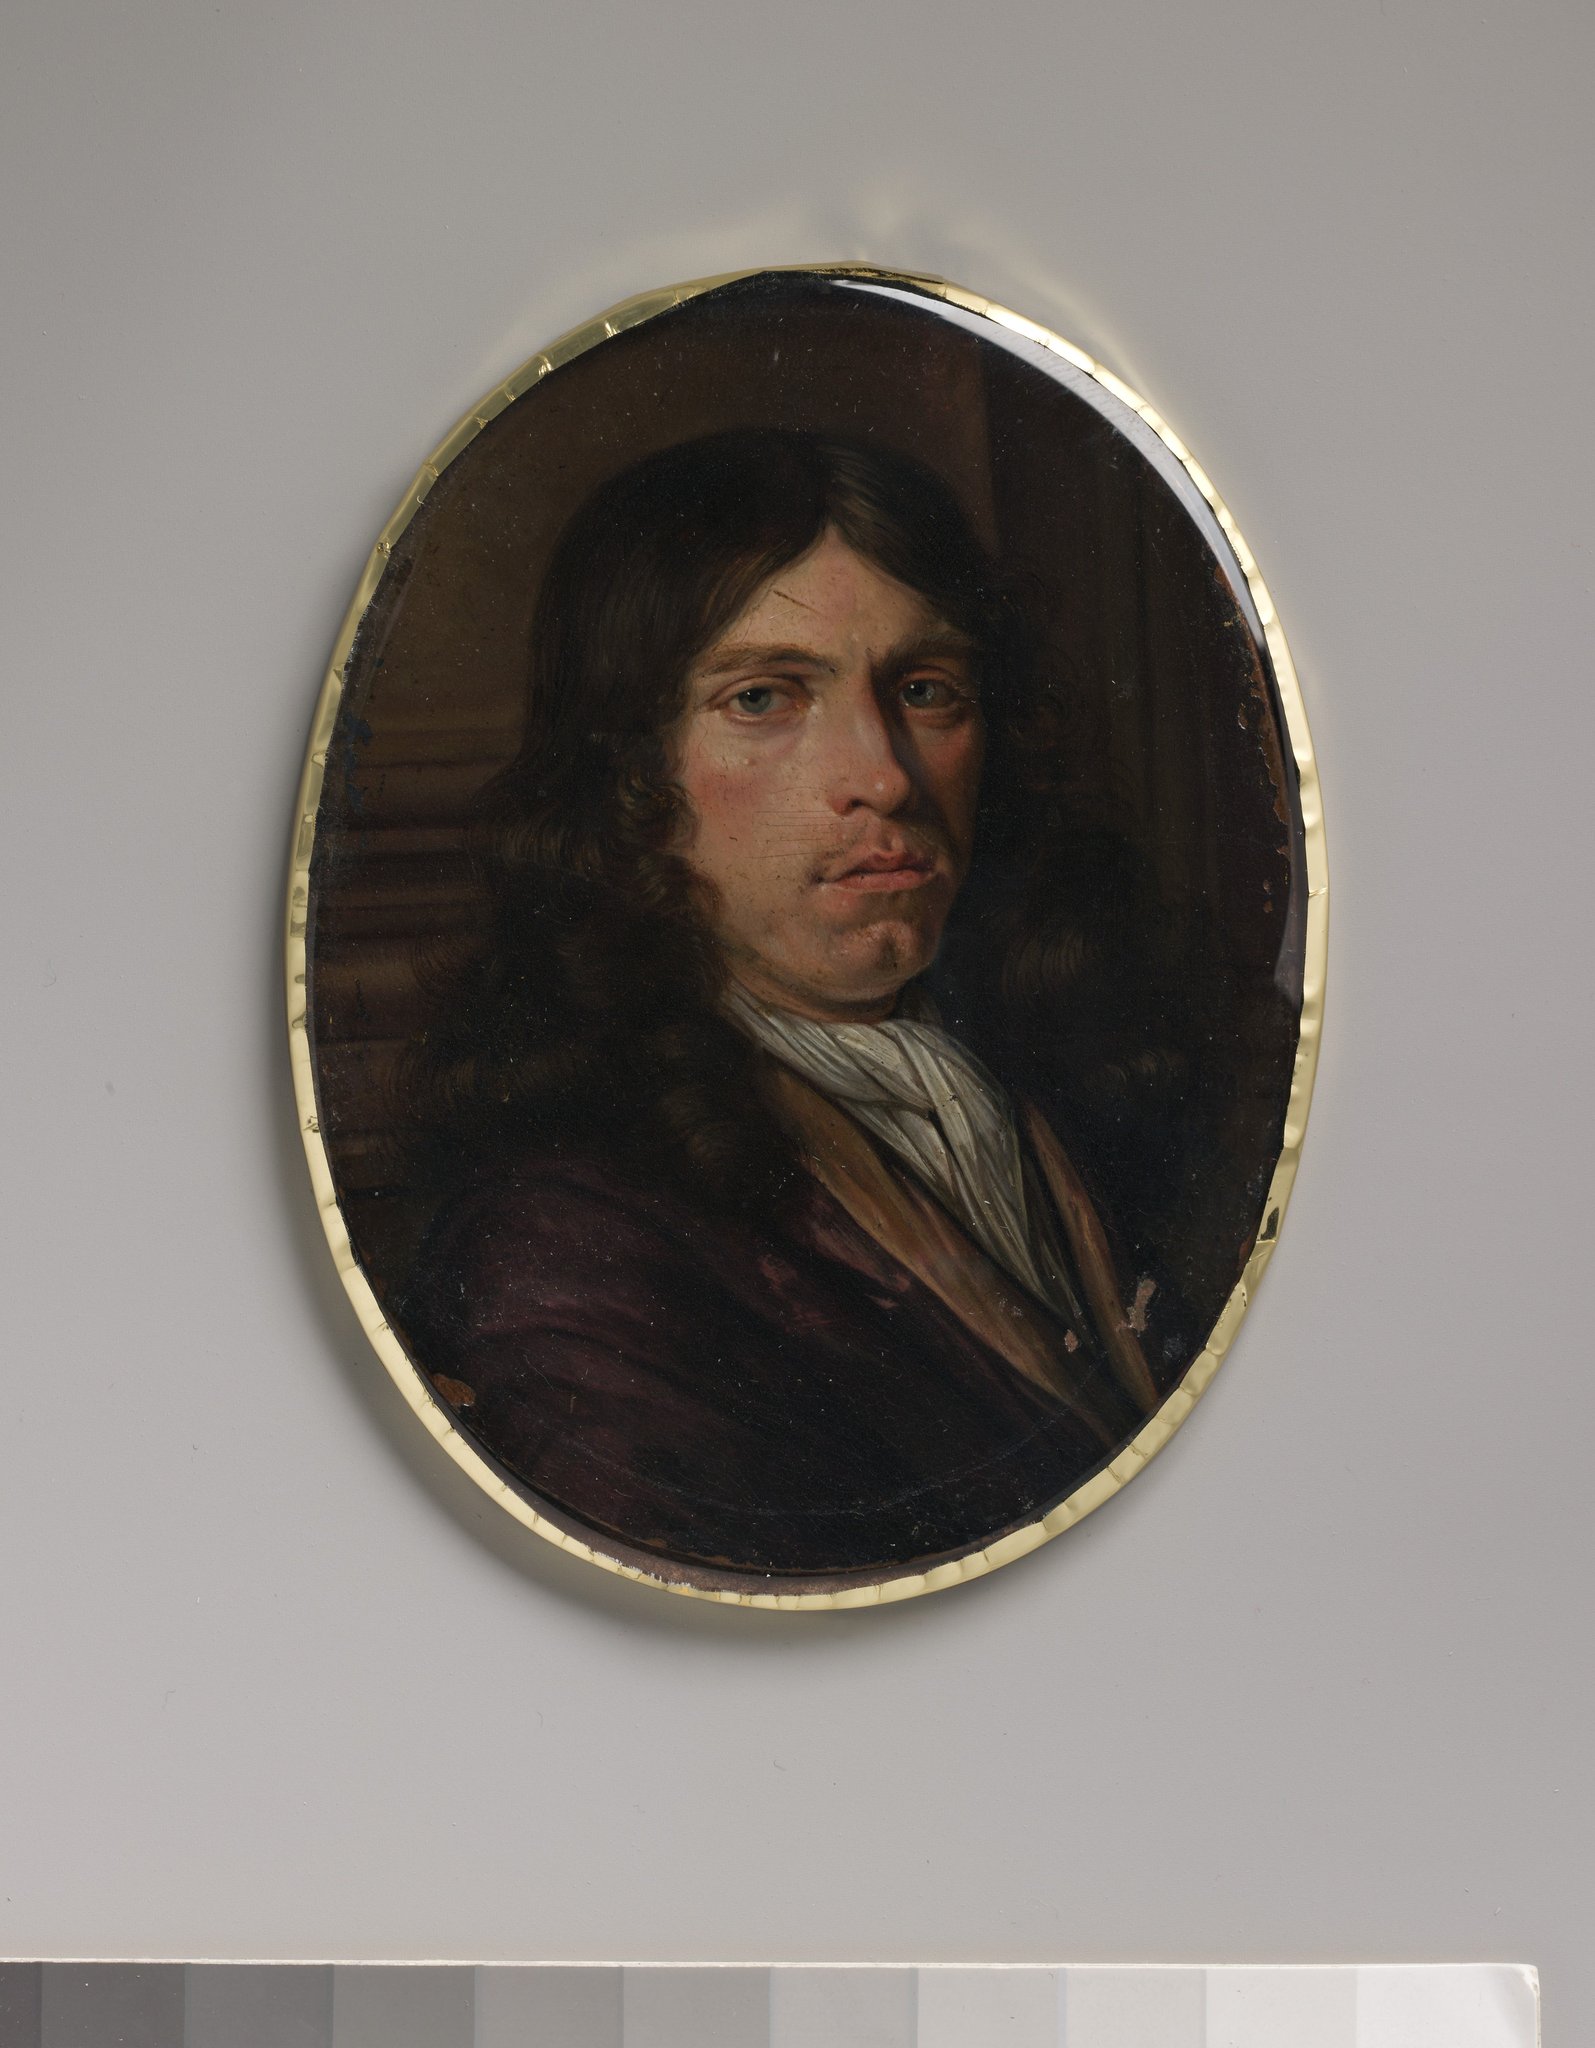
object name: painting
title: Portrait of a Man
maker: pieter van slingelandt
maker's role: artist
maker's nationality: dutch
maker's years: 1640-1691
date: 1680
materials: copper, oil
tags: men,portraits